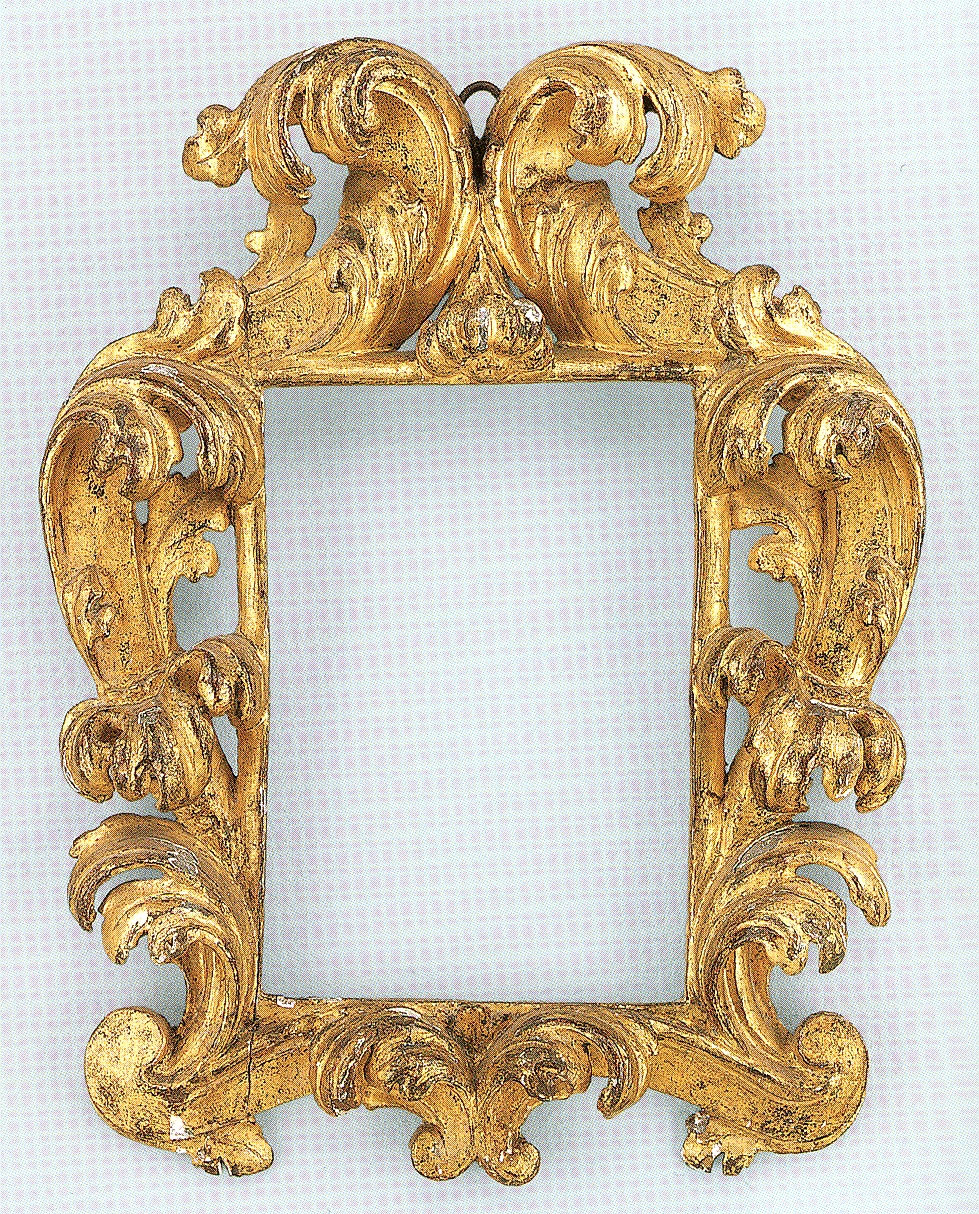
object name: frame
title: Cauliculi frame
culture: italian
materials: wood